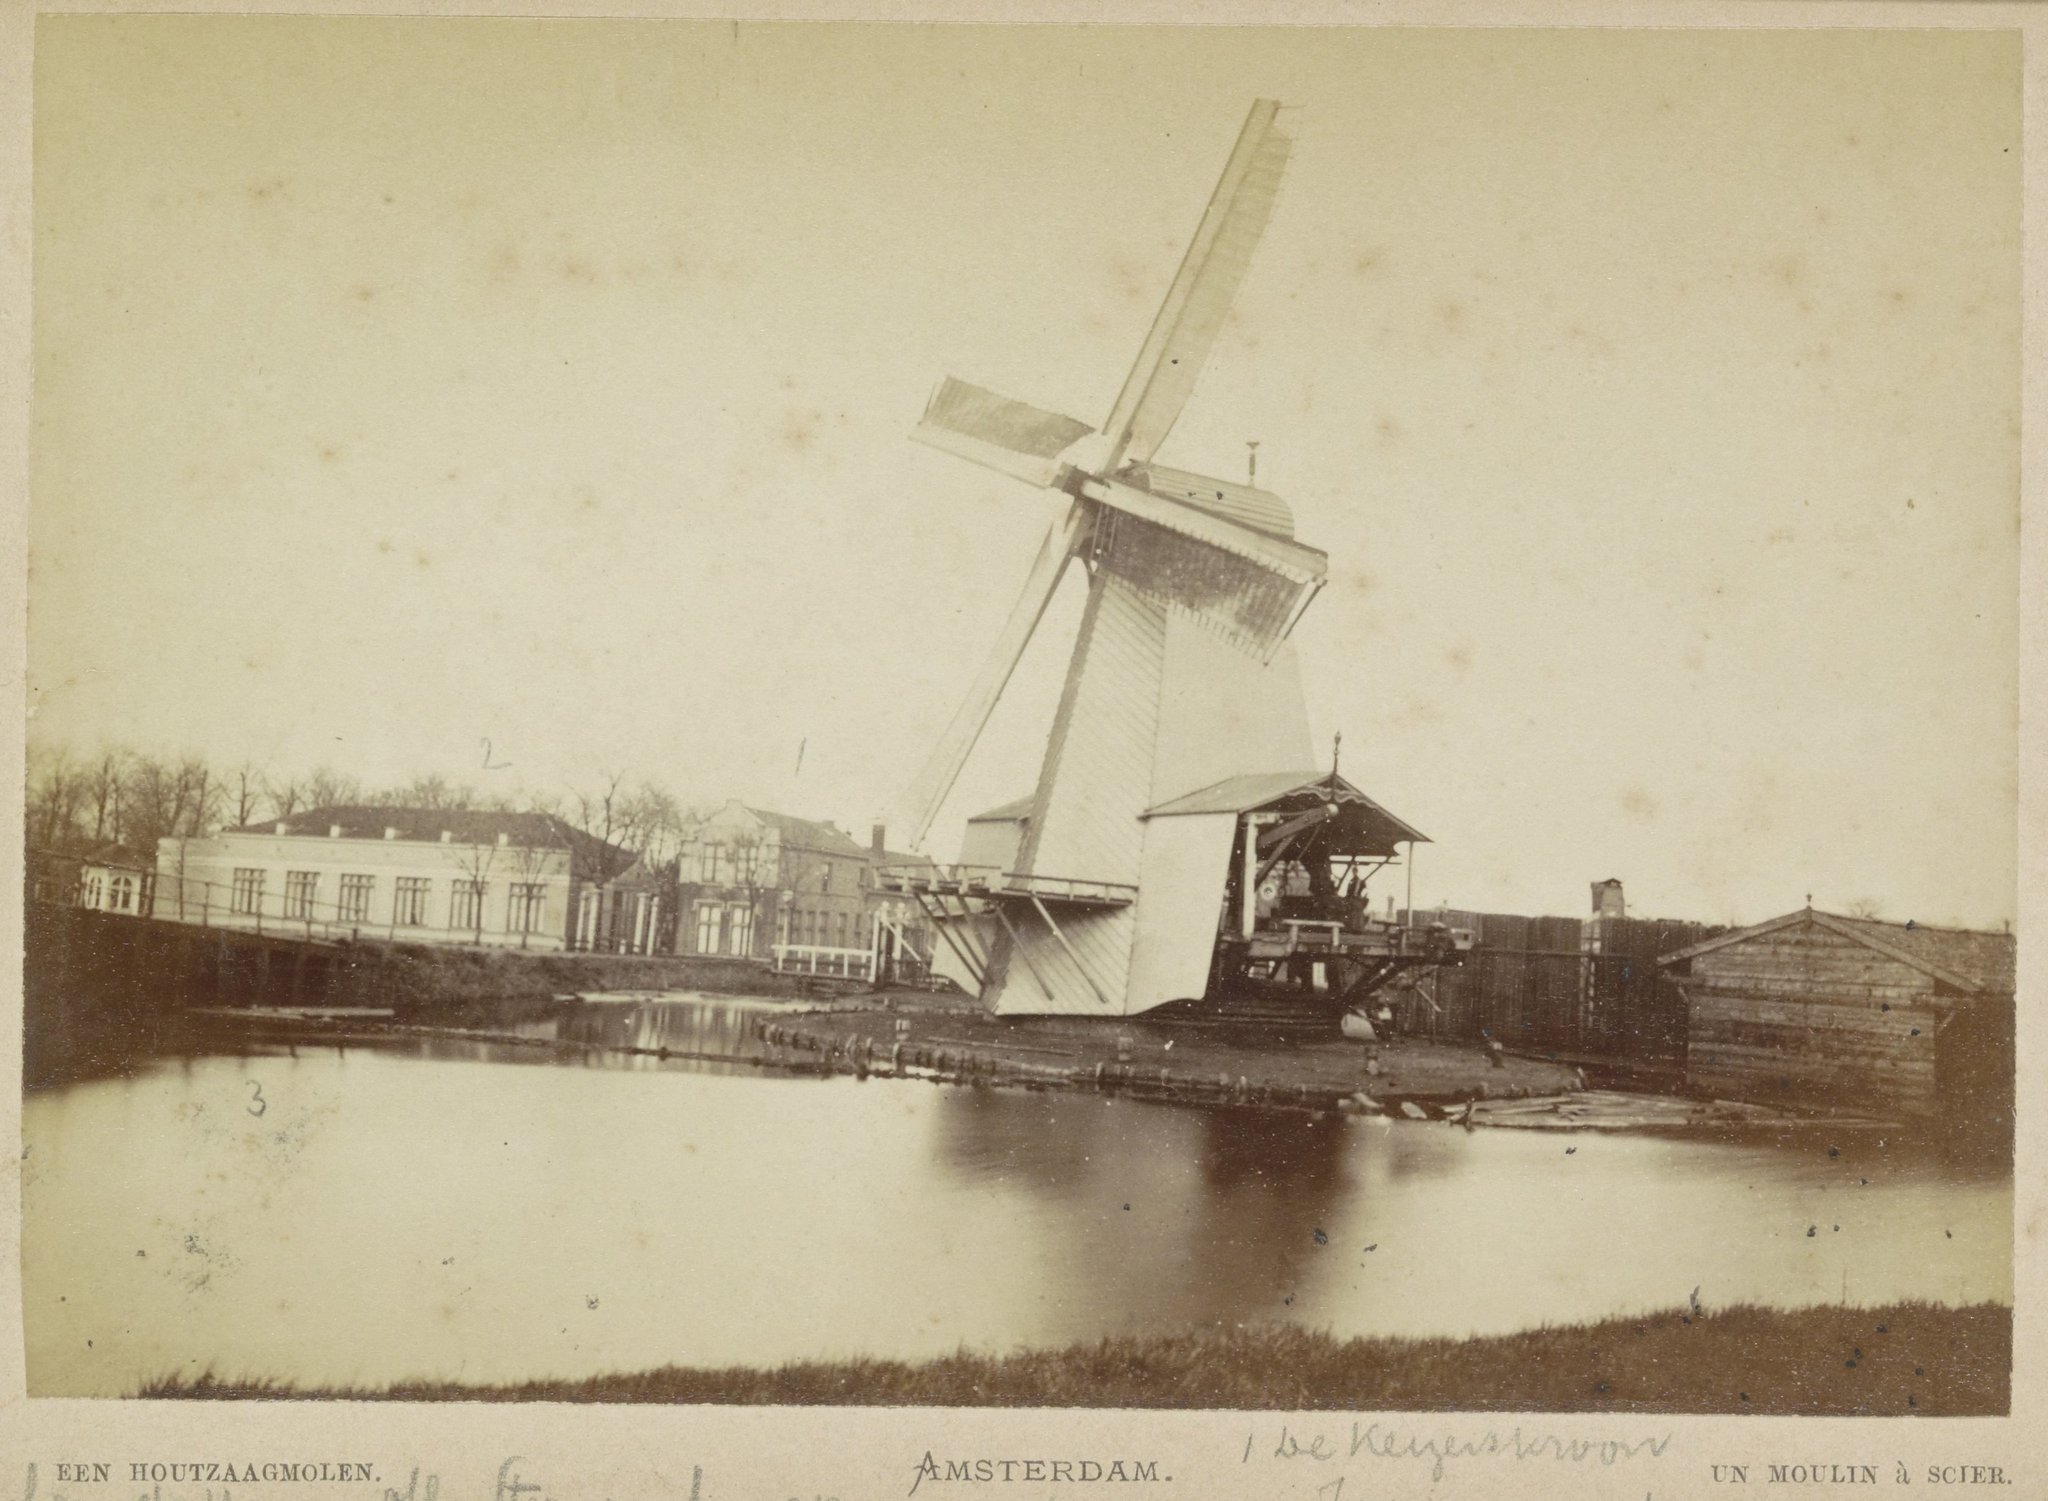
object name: cabinet photograph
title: Een houtzaagmolen. Amsterdam. Un moulin à scier.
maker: andries jager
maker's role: publisher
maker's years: 1825-1905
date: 1880-1900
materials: cardboard, photographic support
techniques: albumen print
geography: amsterdam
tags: pond, pool, windmill, amsterdam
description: Onderdeel van Leporelloalbum met twaalf foto's van Amsterdam.